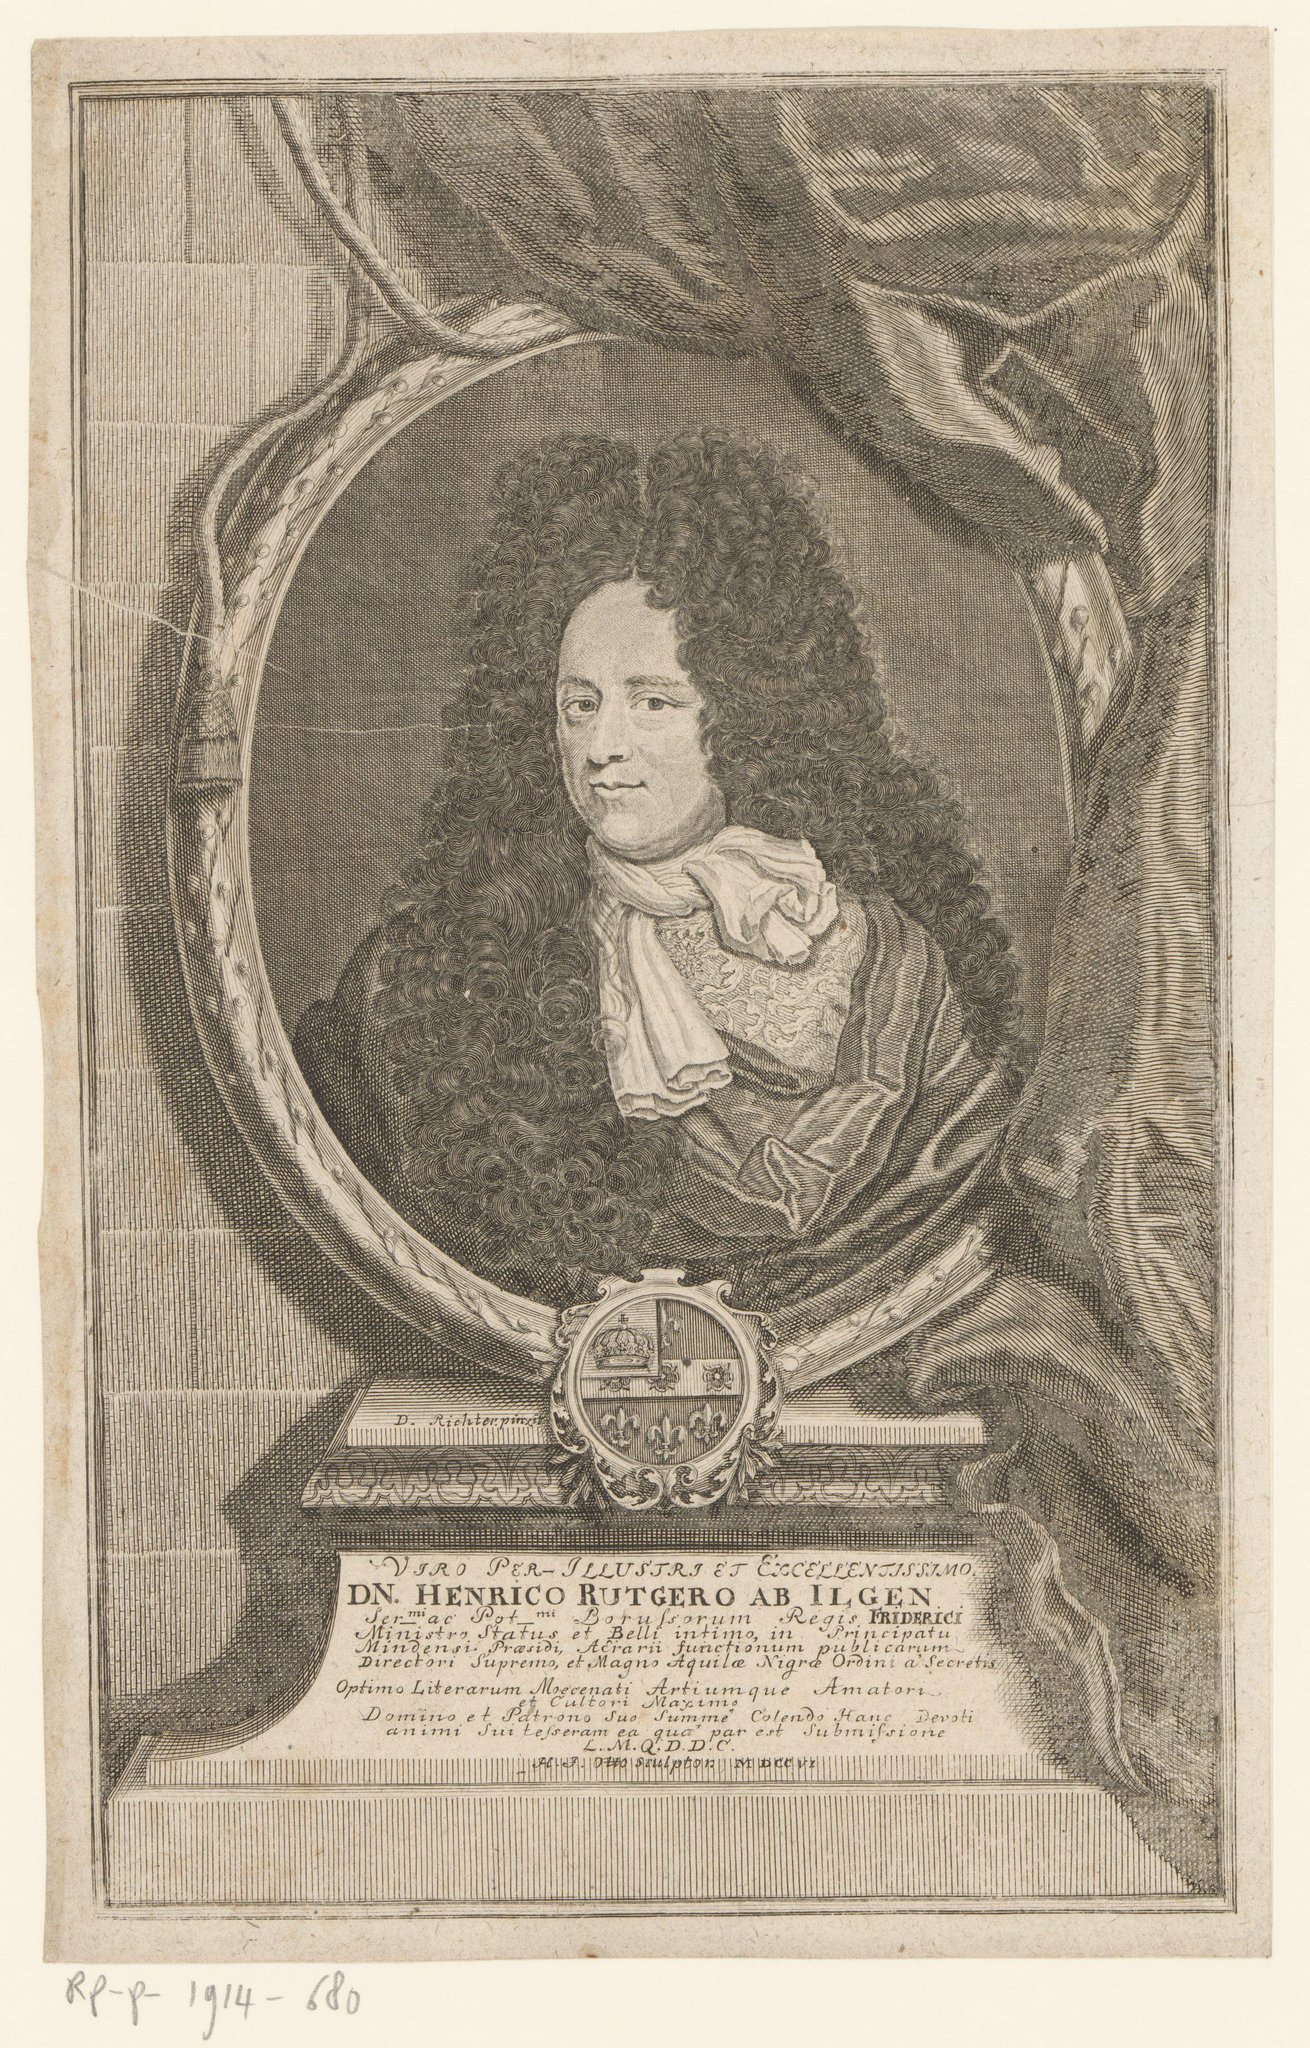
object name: print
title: Portret van Heinrich Rüdiger Ilgen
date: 1669-1749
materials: paper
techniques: engraving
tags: berlin, historical persons, armorial bearing, heraldry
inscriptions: collector's mark: Lugt 2228